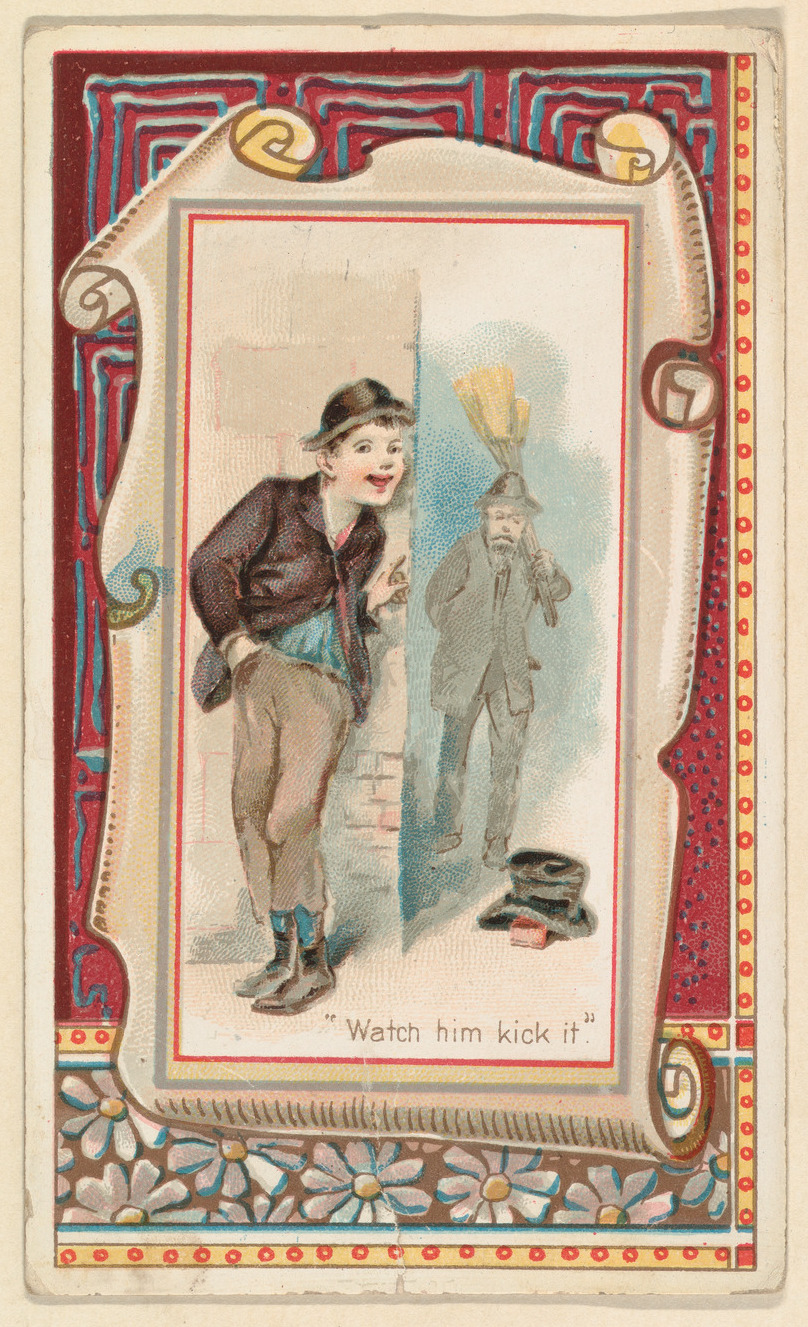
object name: print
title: "Watch him kick it," from the Terrors of America set (N136) issued by Duke Sons & Co. to promote Honest Long Cut Tobacco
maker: w. duke, sons & co.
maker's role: publisher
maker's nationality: american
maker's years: 1870-1920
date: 1888-1889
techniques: color lithograph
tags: boys,men